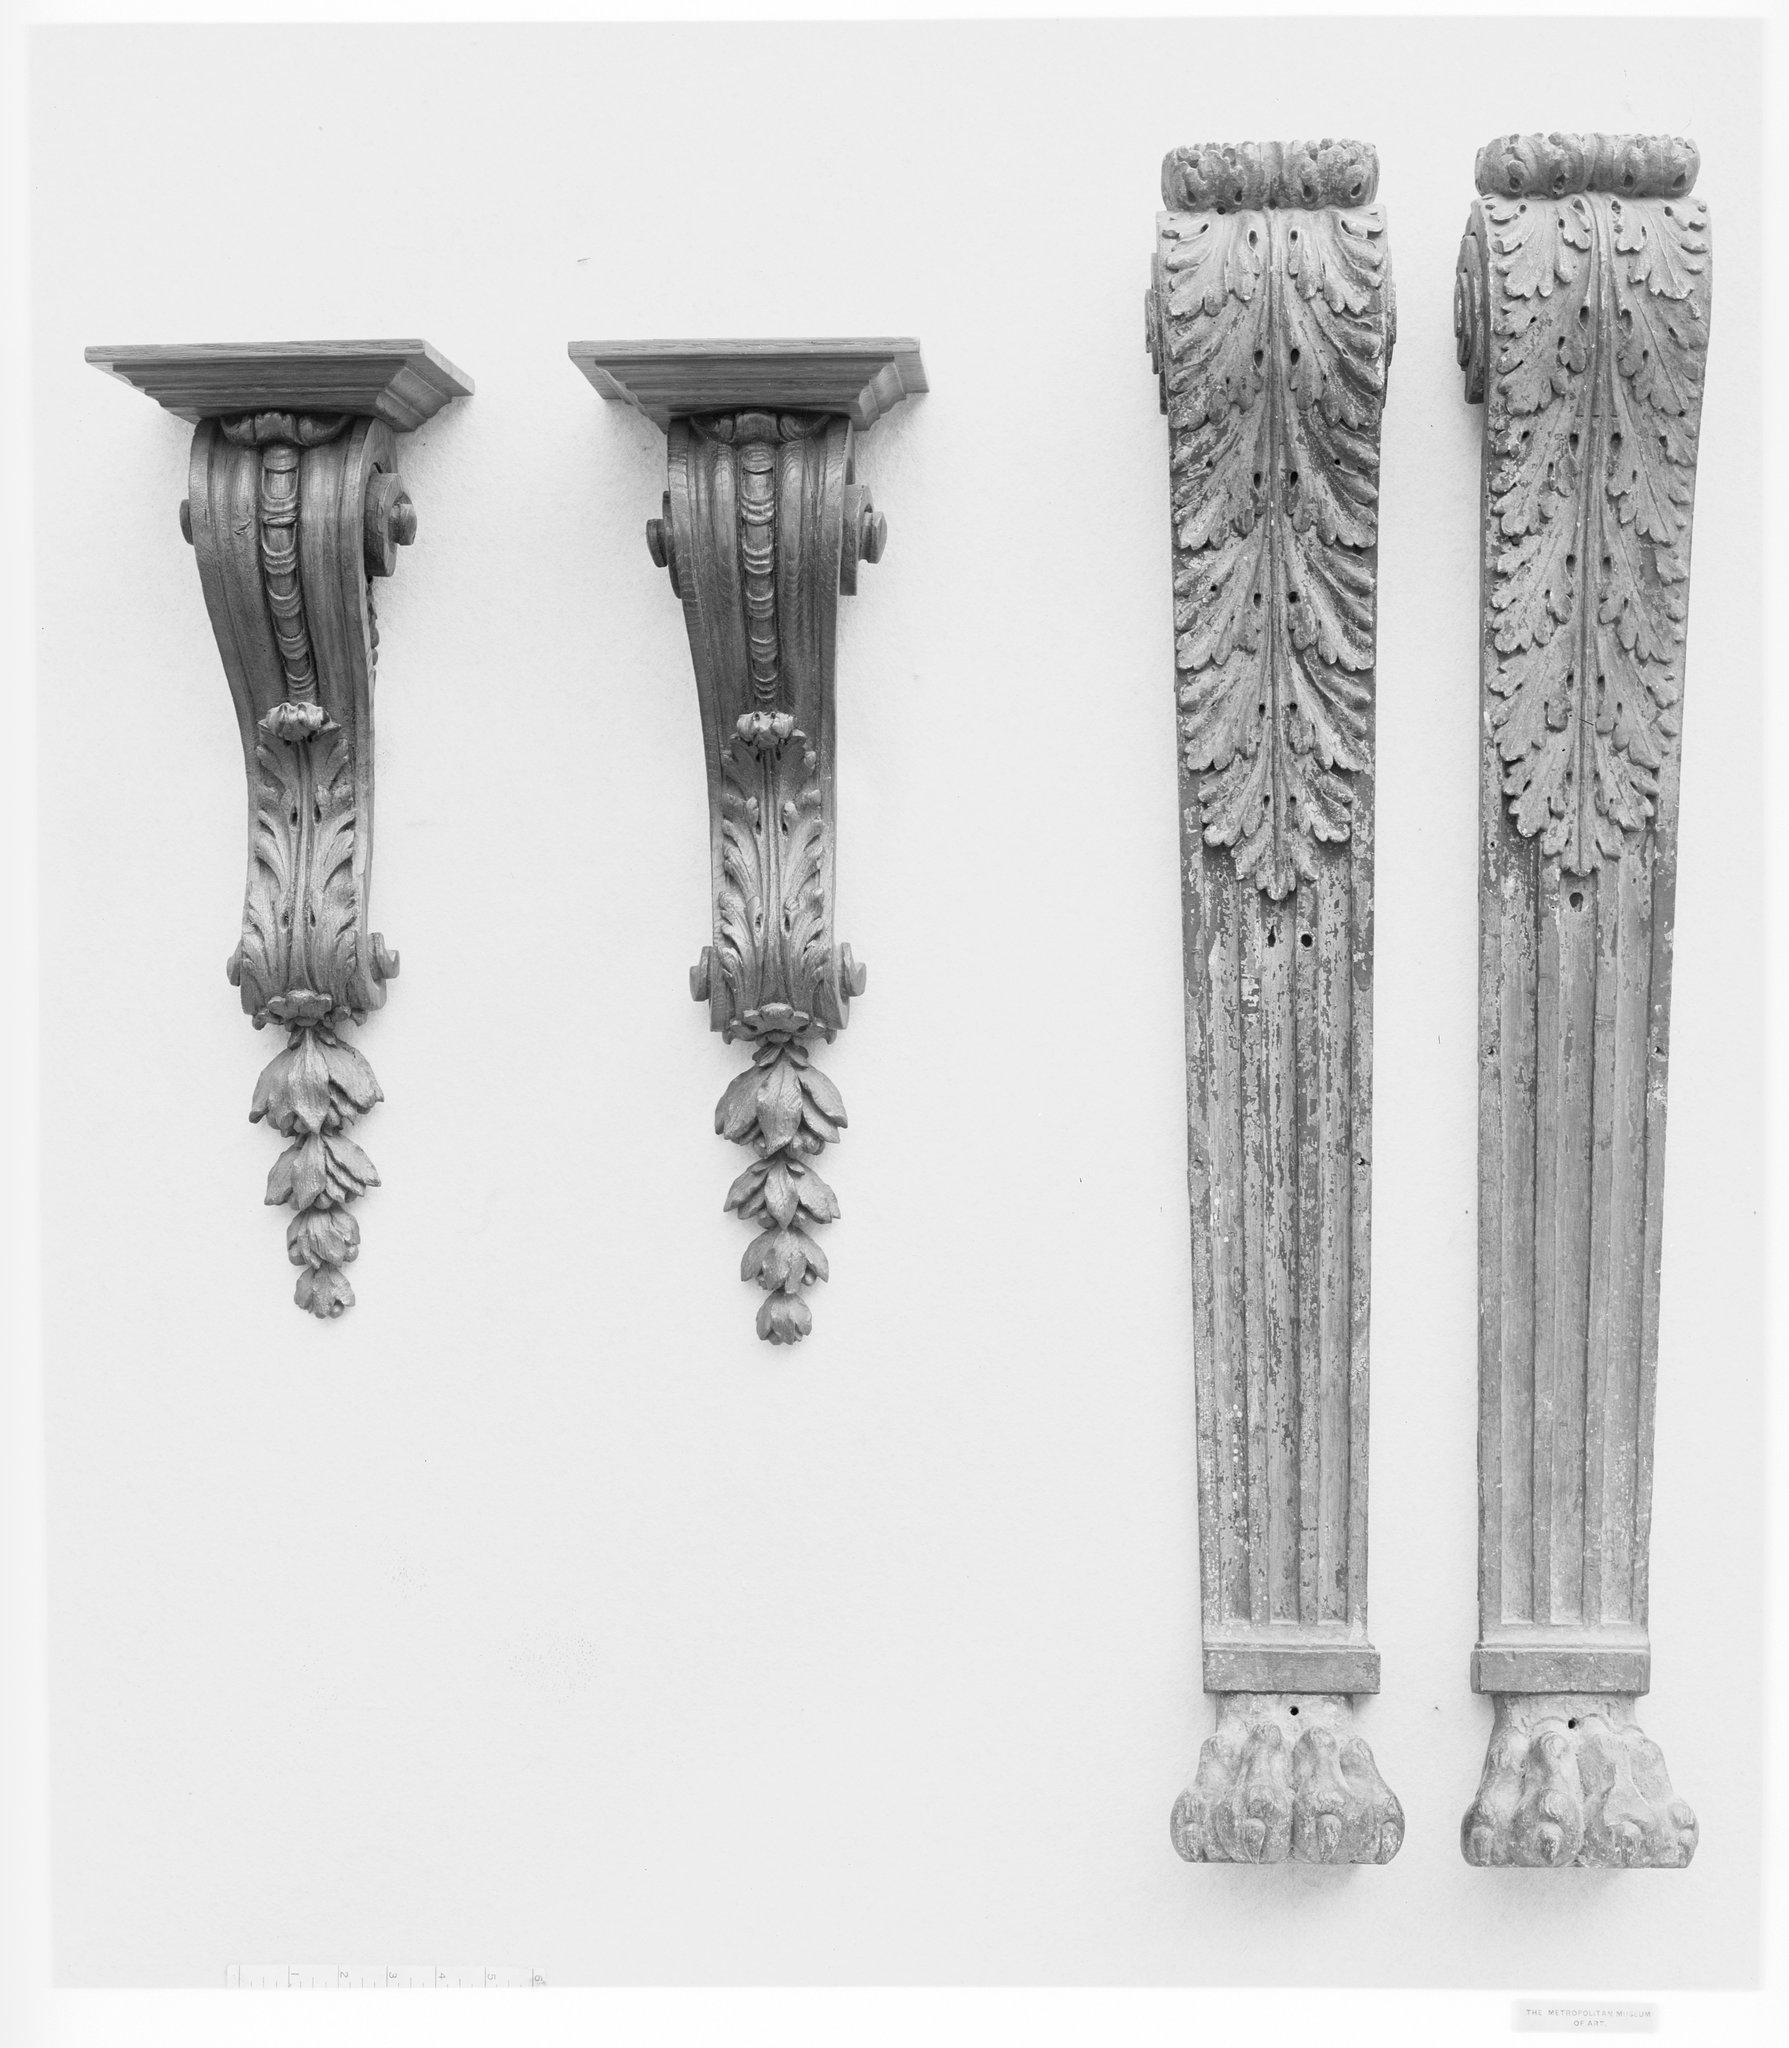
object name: console table leg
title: Console table legs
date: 1701-1800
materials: gilt, wood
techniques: carving